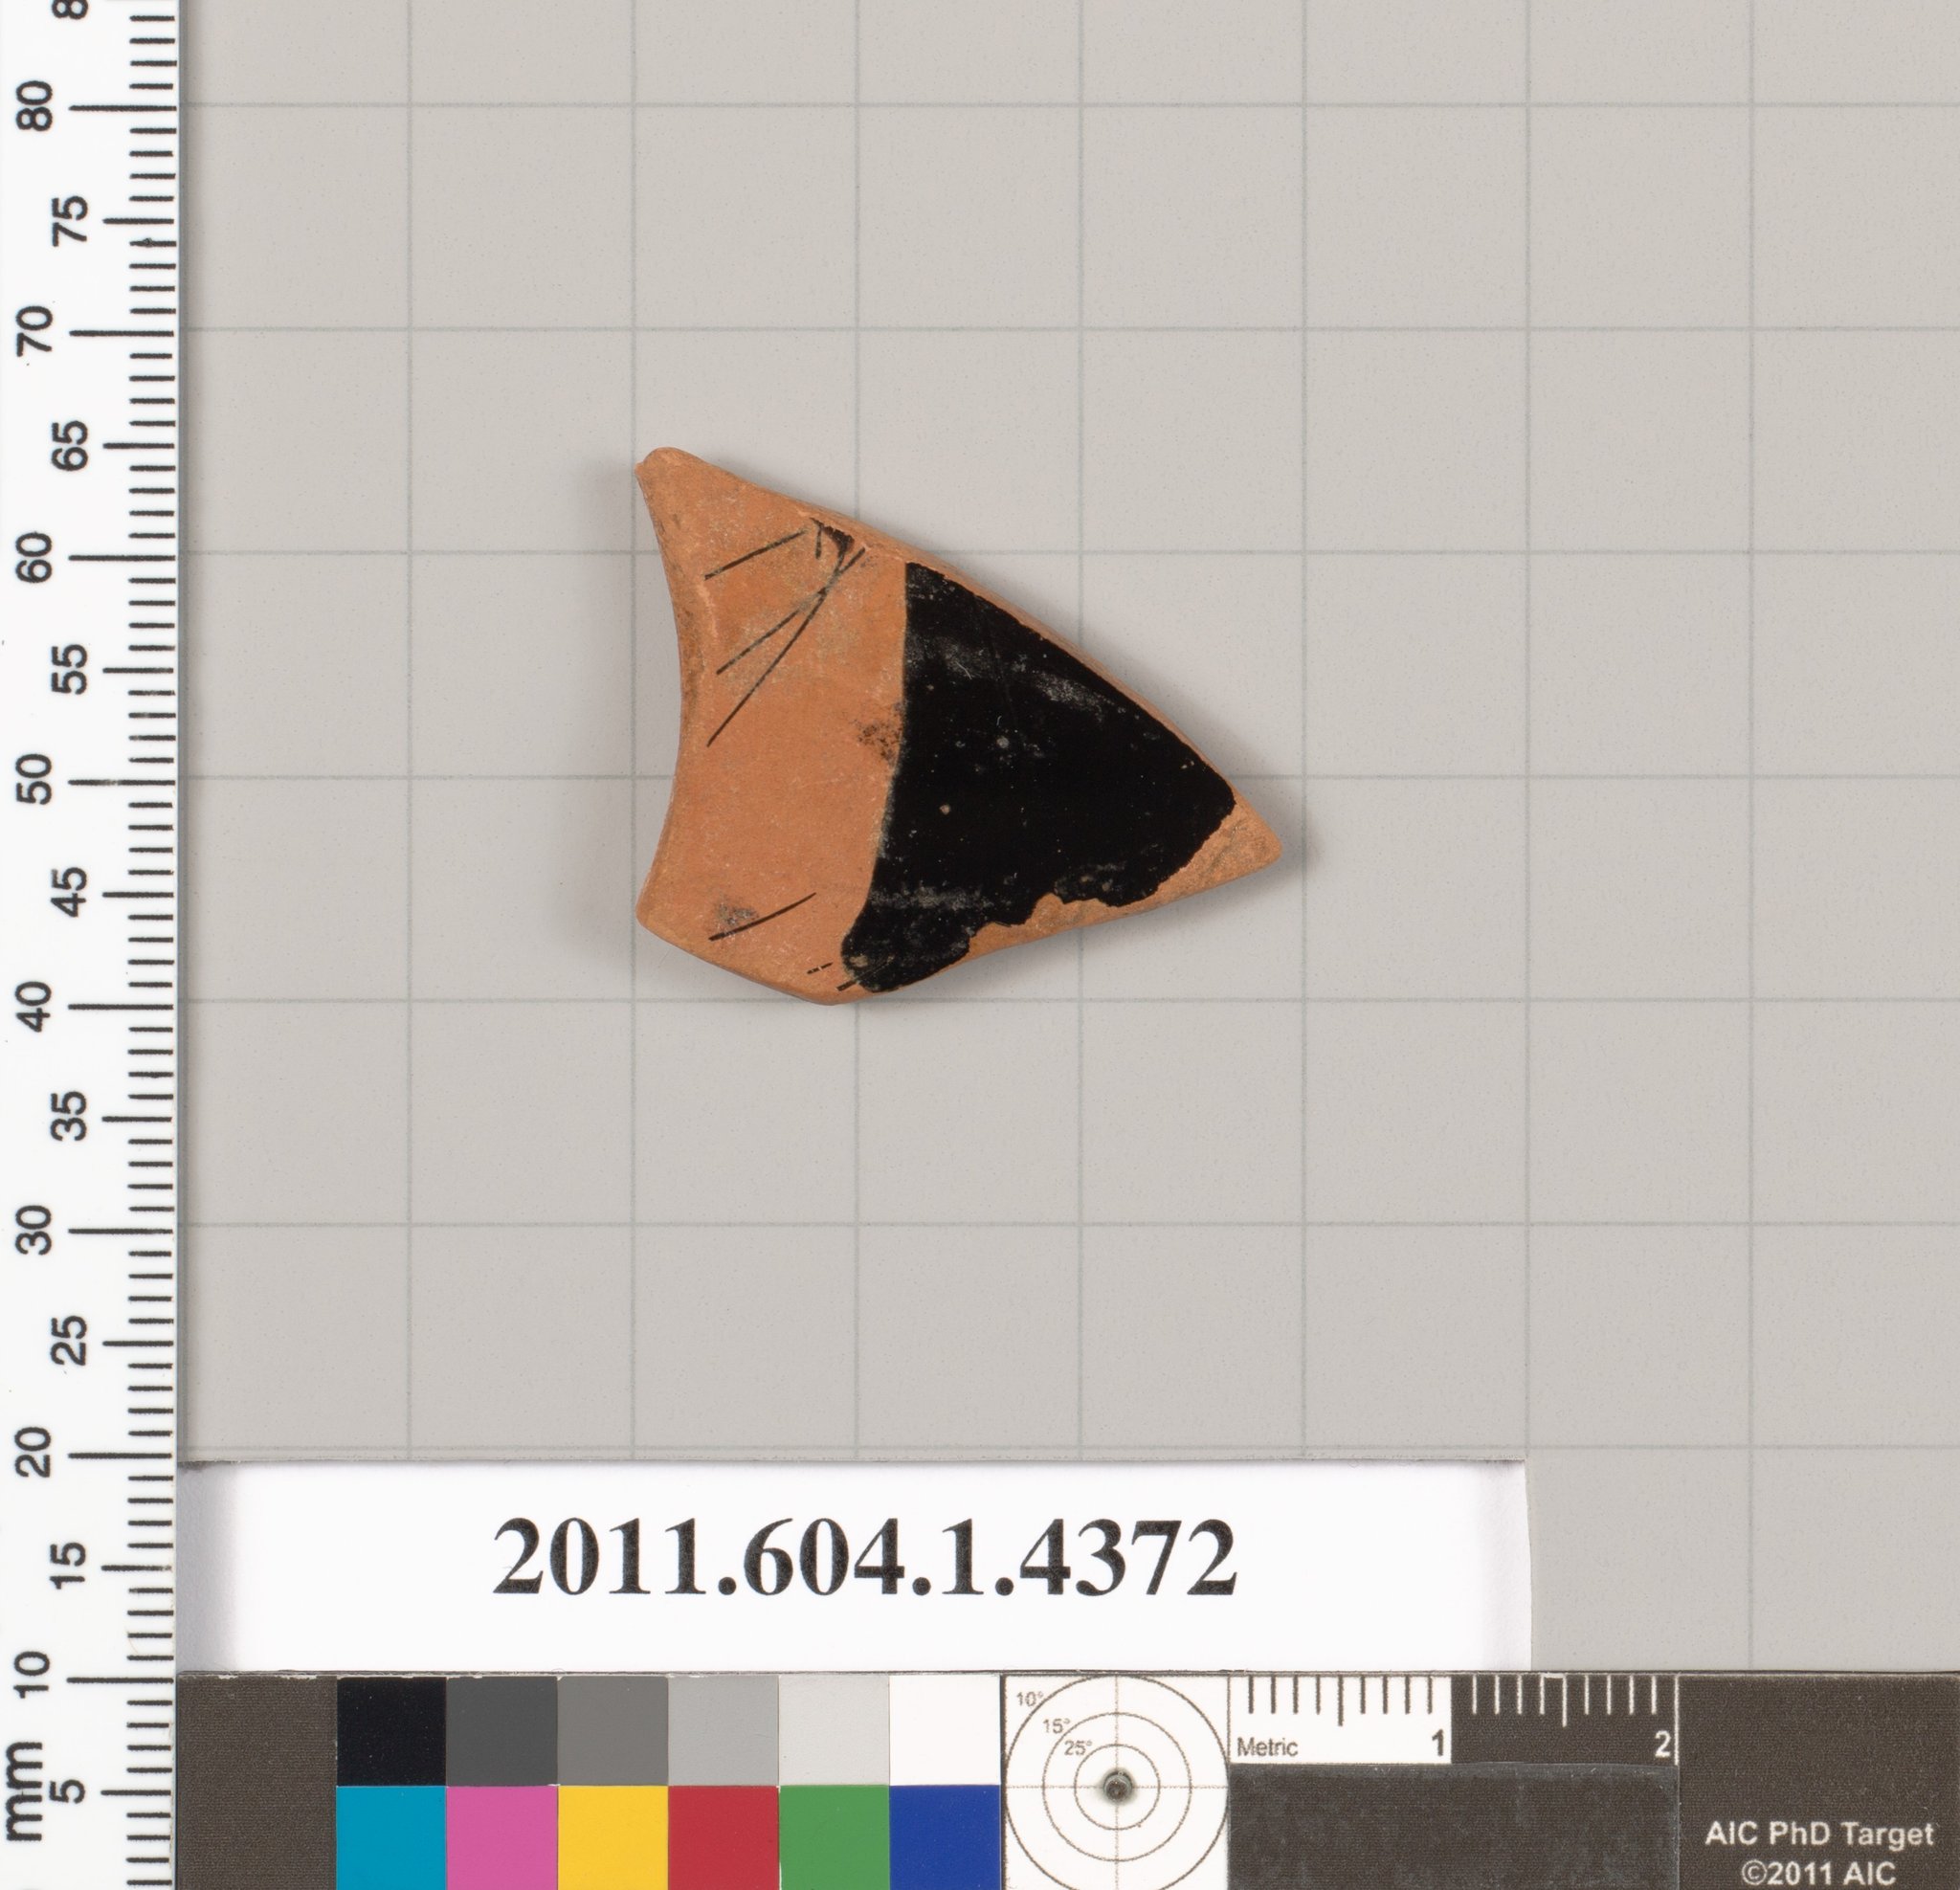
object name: kylix fragment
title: Terracotta fragment of a kylix (drinking cup)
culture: greek, attic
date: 467-435 BCE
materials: terracotta